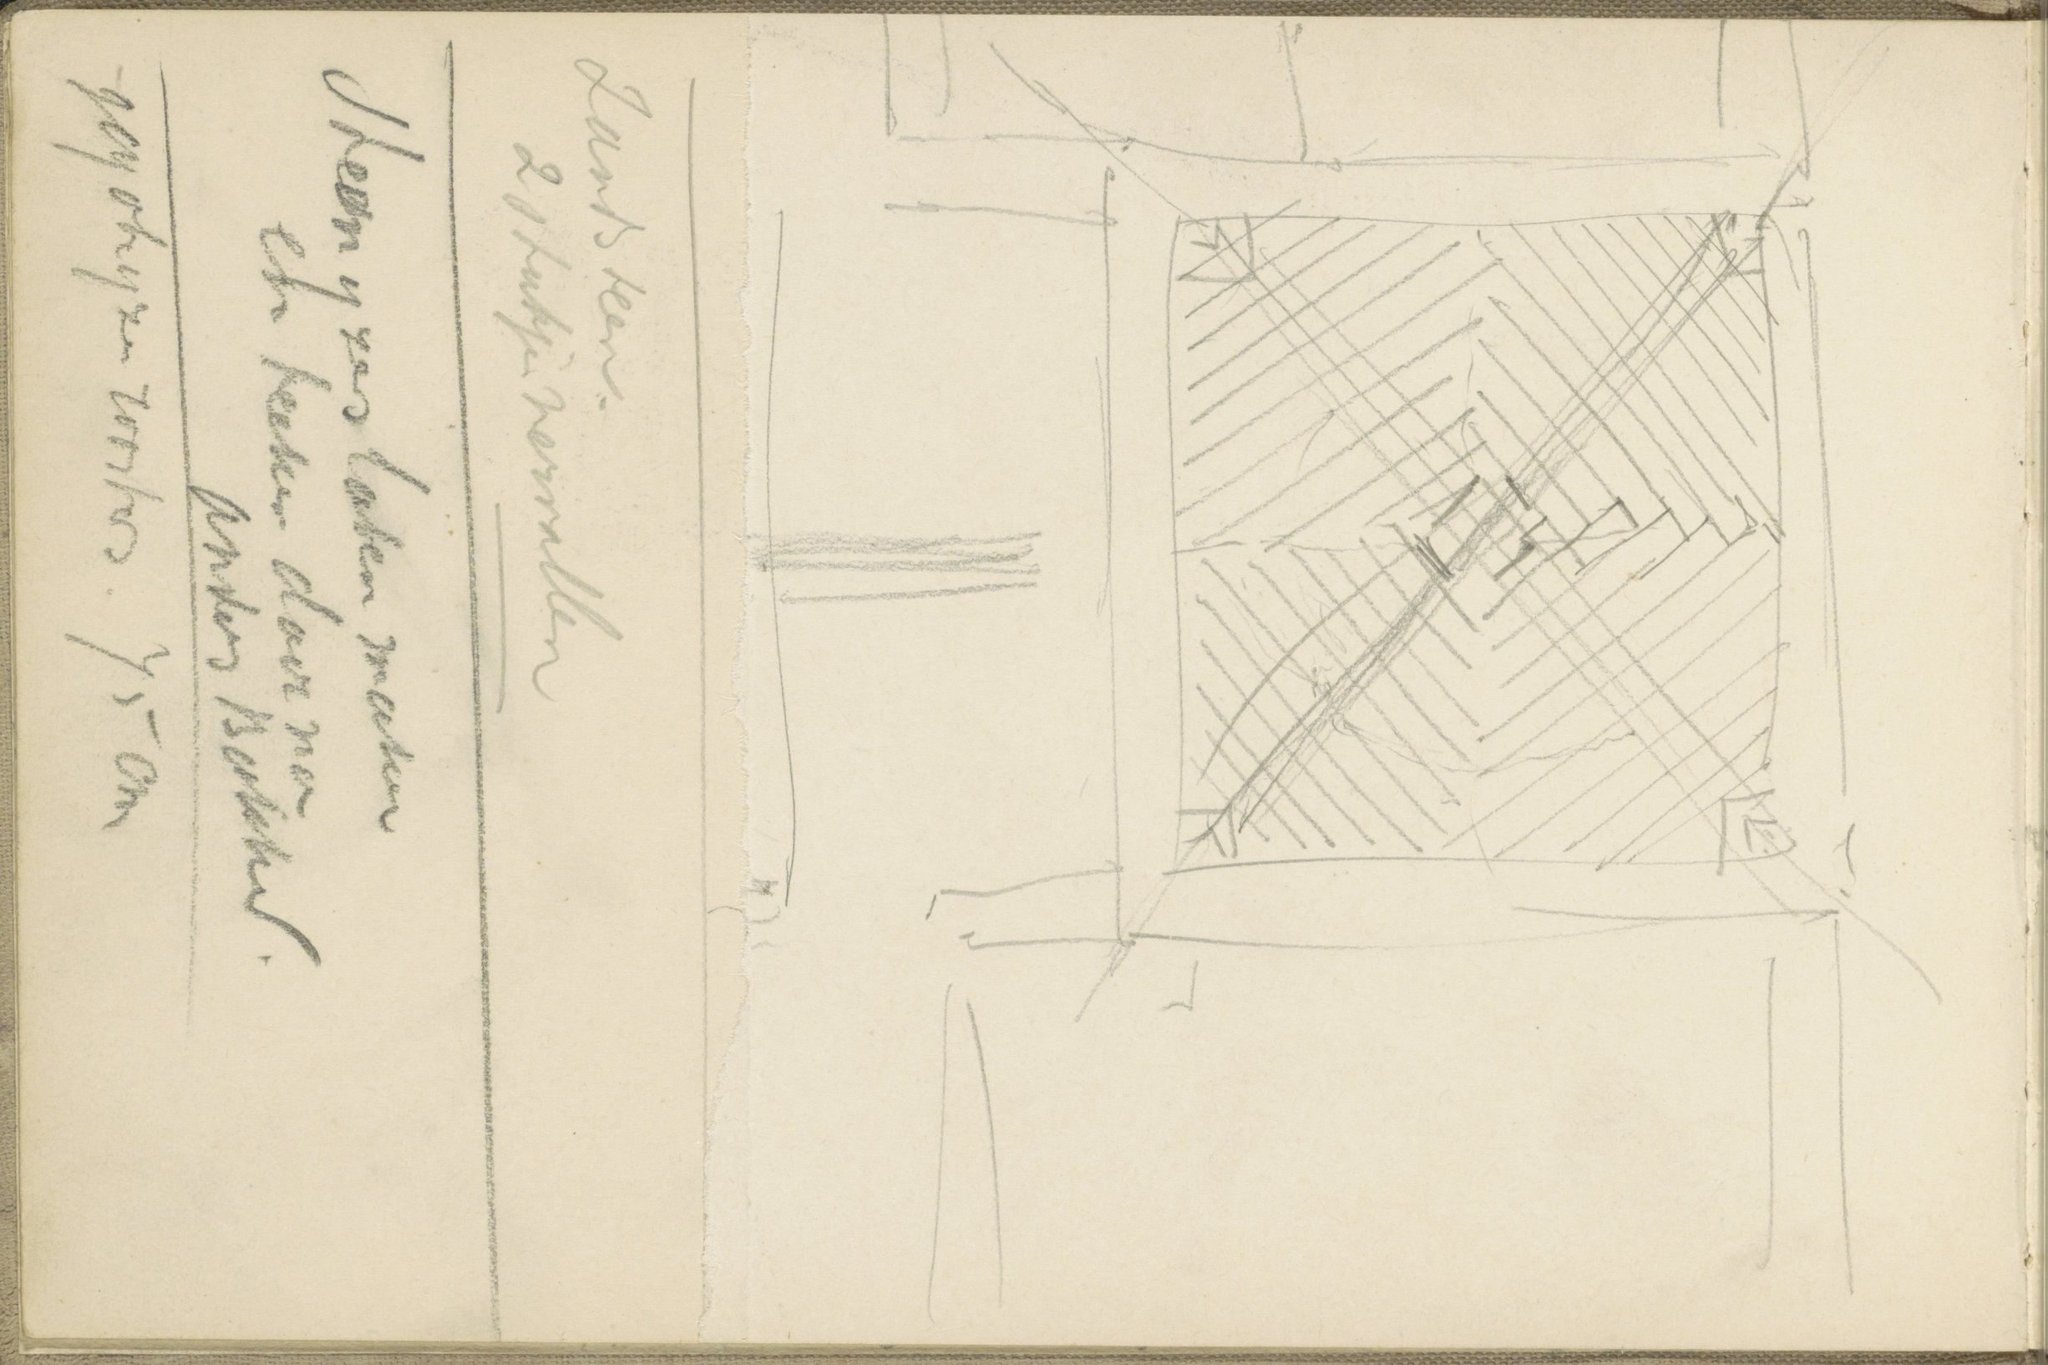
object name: sketchbook leaf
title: Vierkant met een lijnmotief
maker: carel adolph lion cachet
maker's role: draughtsman, print maker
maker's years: 1864-1945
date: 1905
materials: paper, pencil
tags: intersecting lines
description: Blad 4 verso uit een schetsboek met 27 bladen.